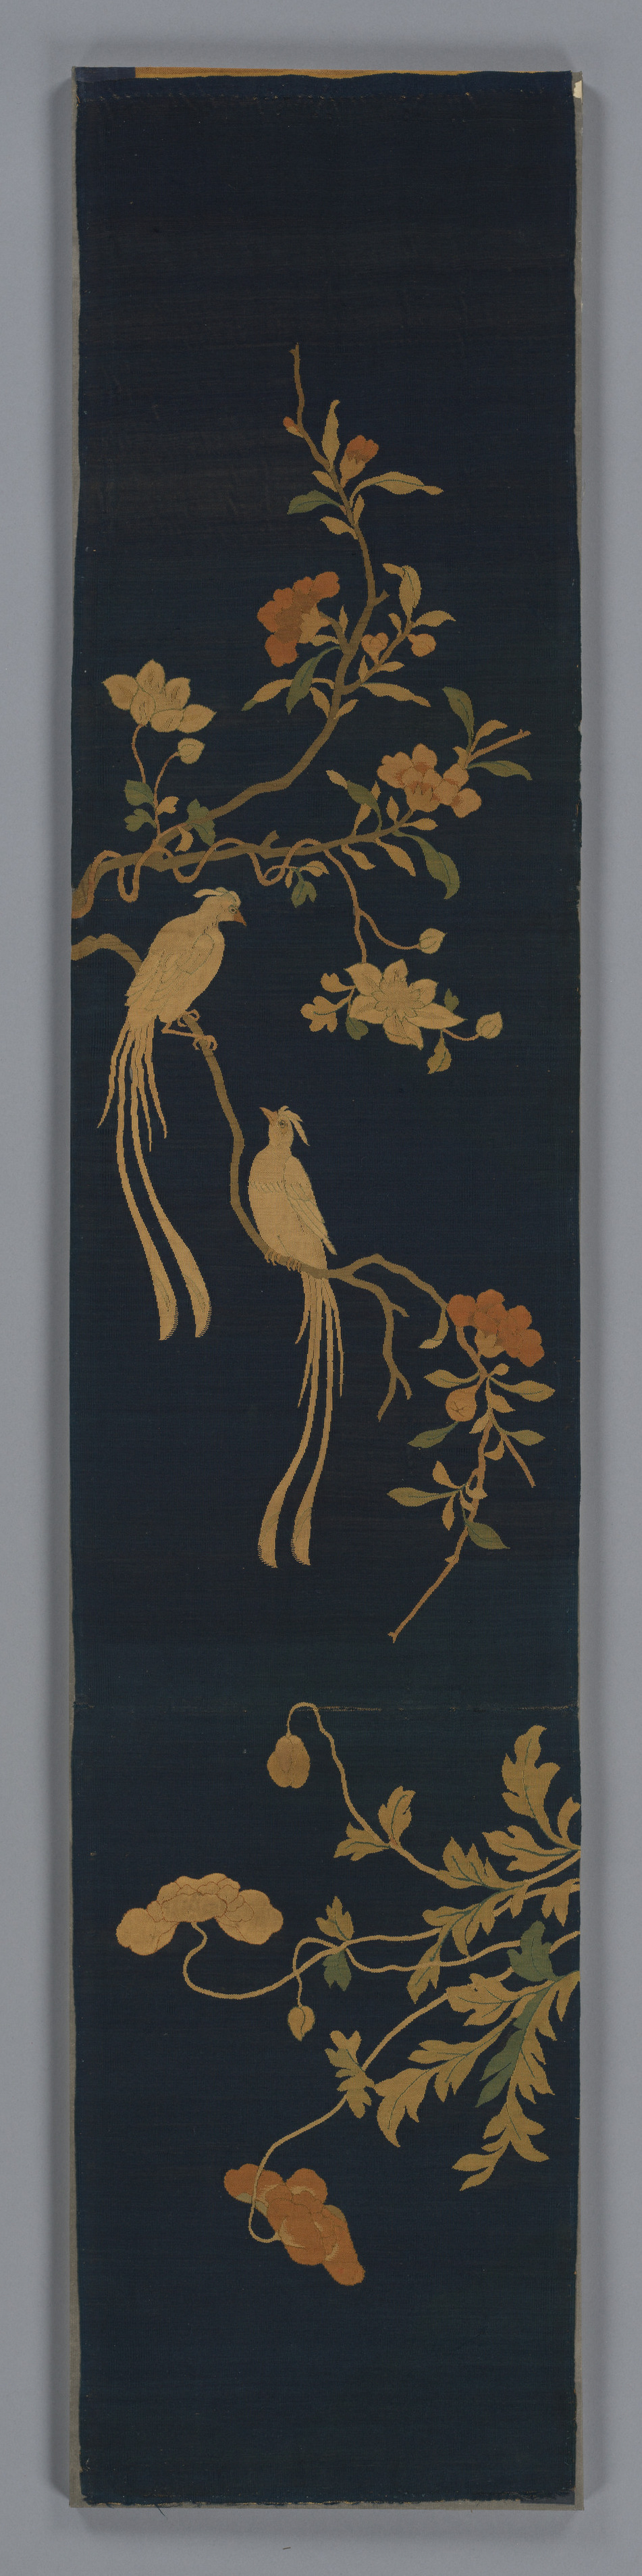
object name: panel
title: Panel with long-tailed birds, camellia, clematis, and poppies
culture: chinese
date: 1701-1800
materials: silk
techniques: tapestry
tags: birds,poppies